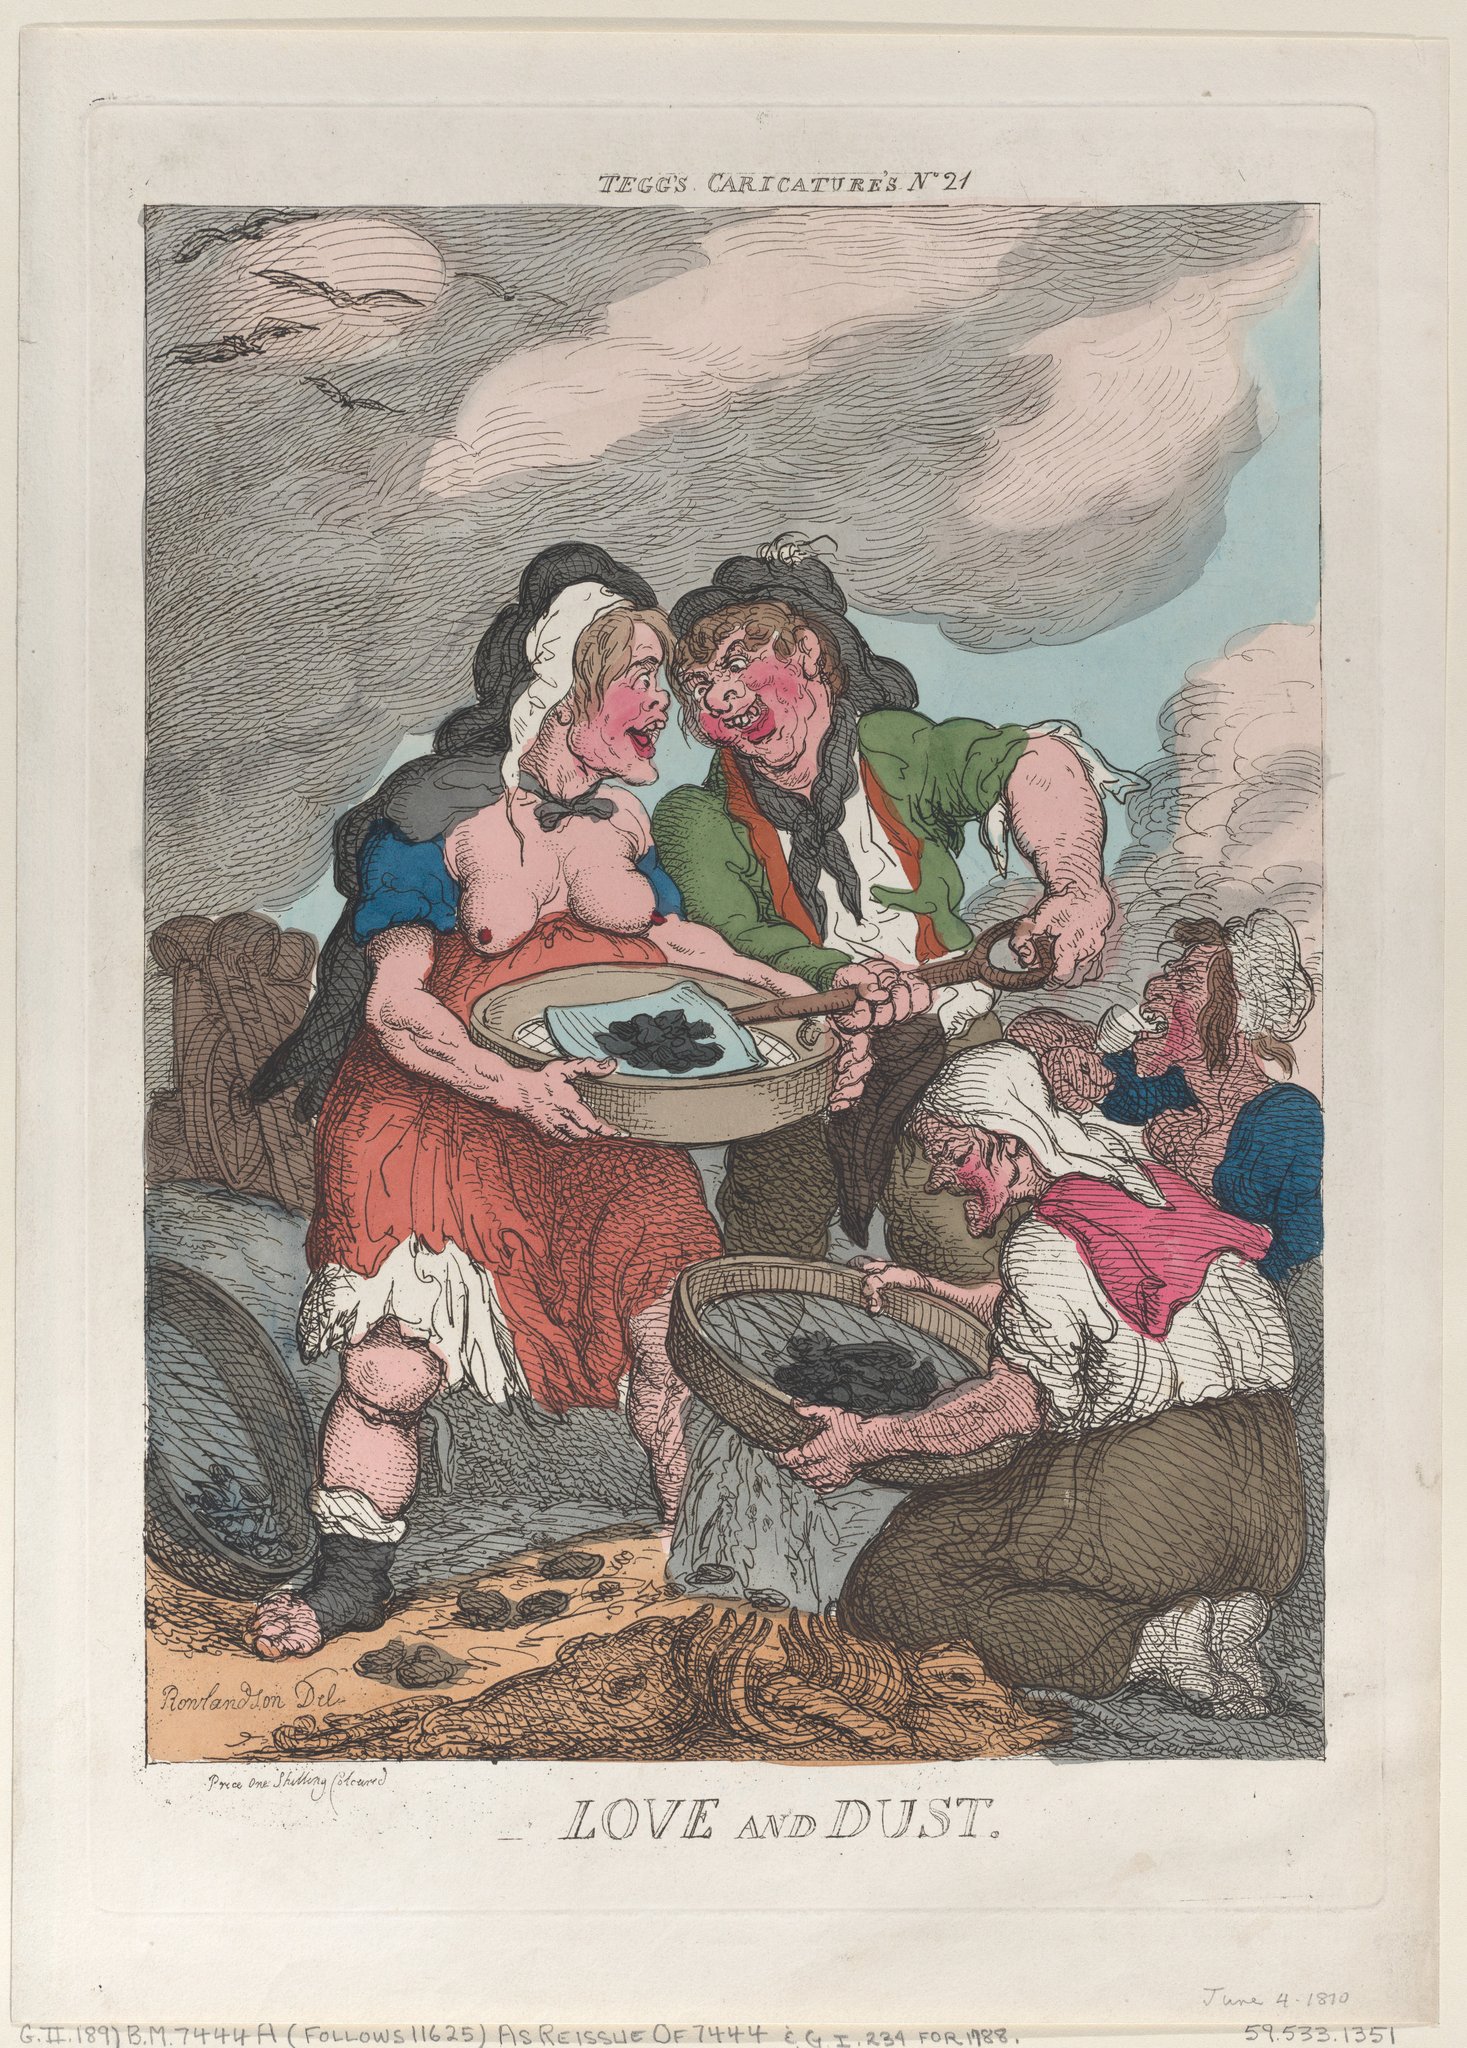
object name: print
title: Love and Dust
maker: thomas rowlandson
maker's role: artist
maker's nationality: british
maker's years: 1757-1827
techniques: etching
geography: london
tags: men,female nudes,caricature